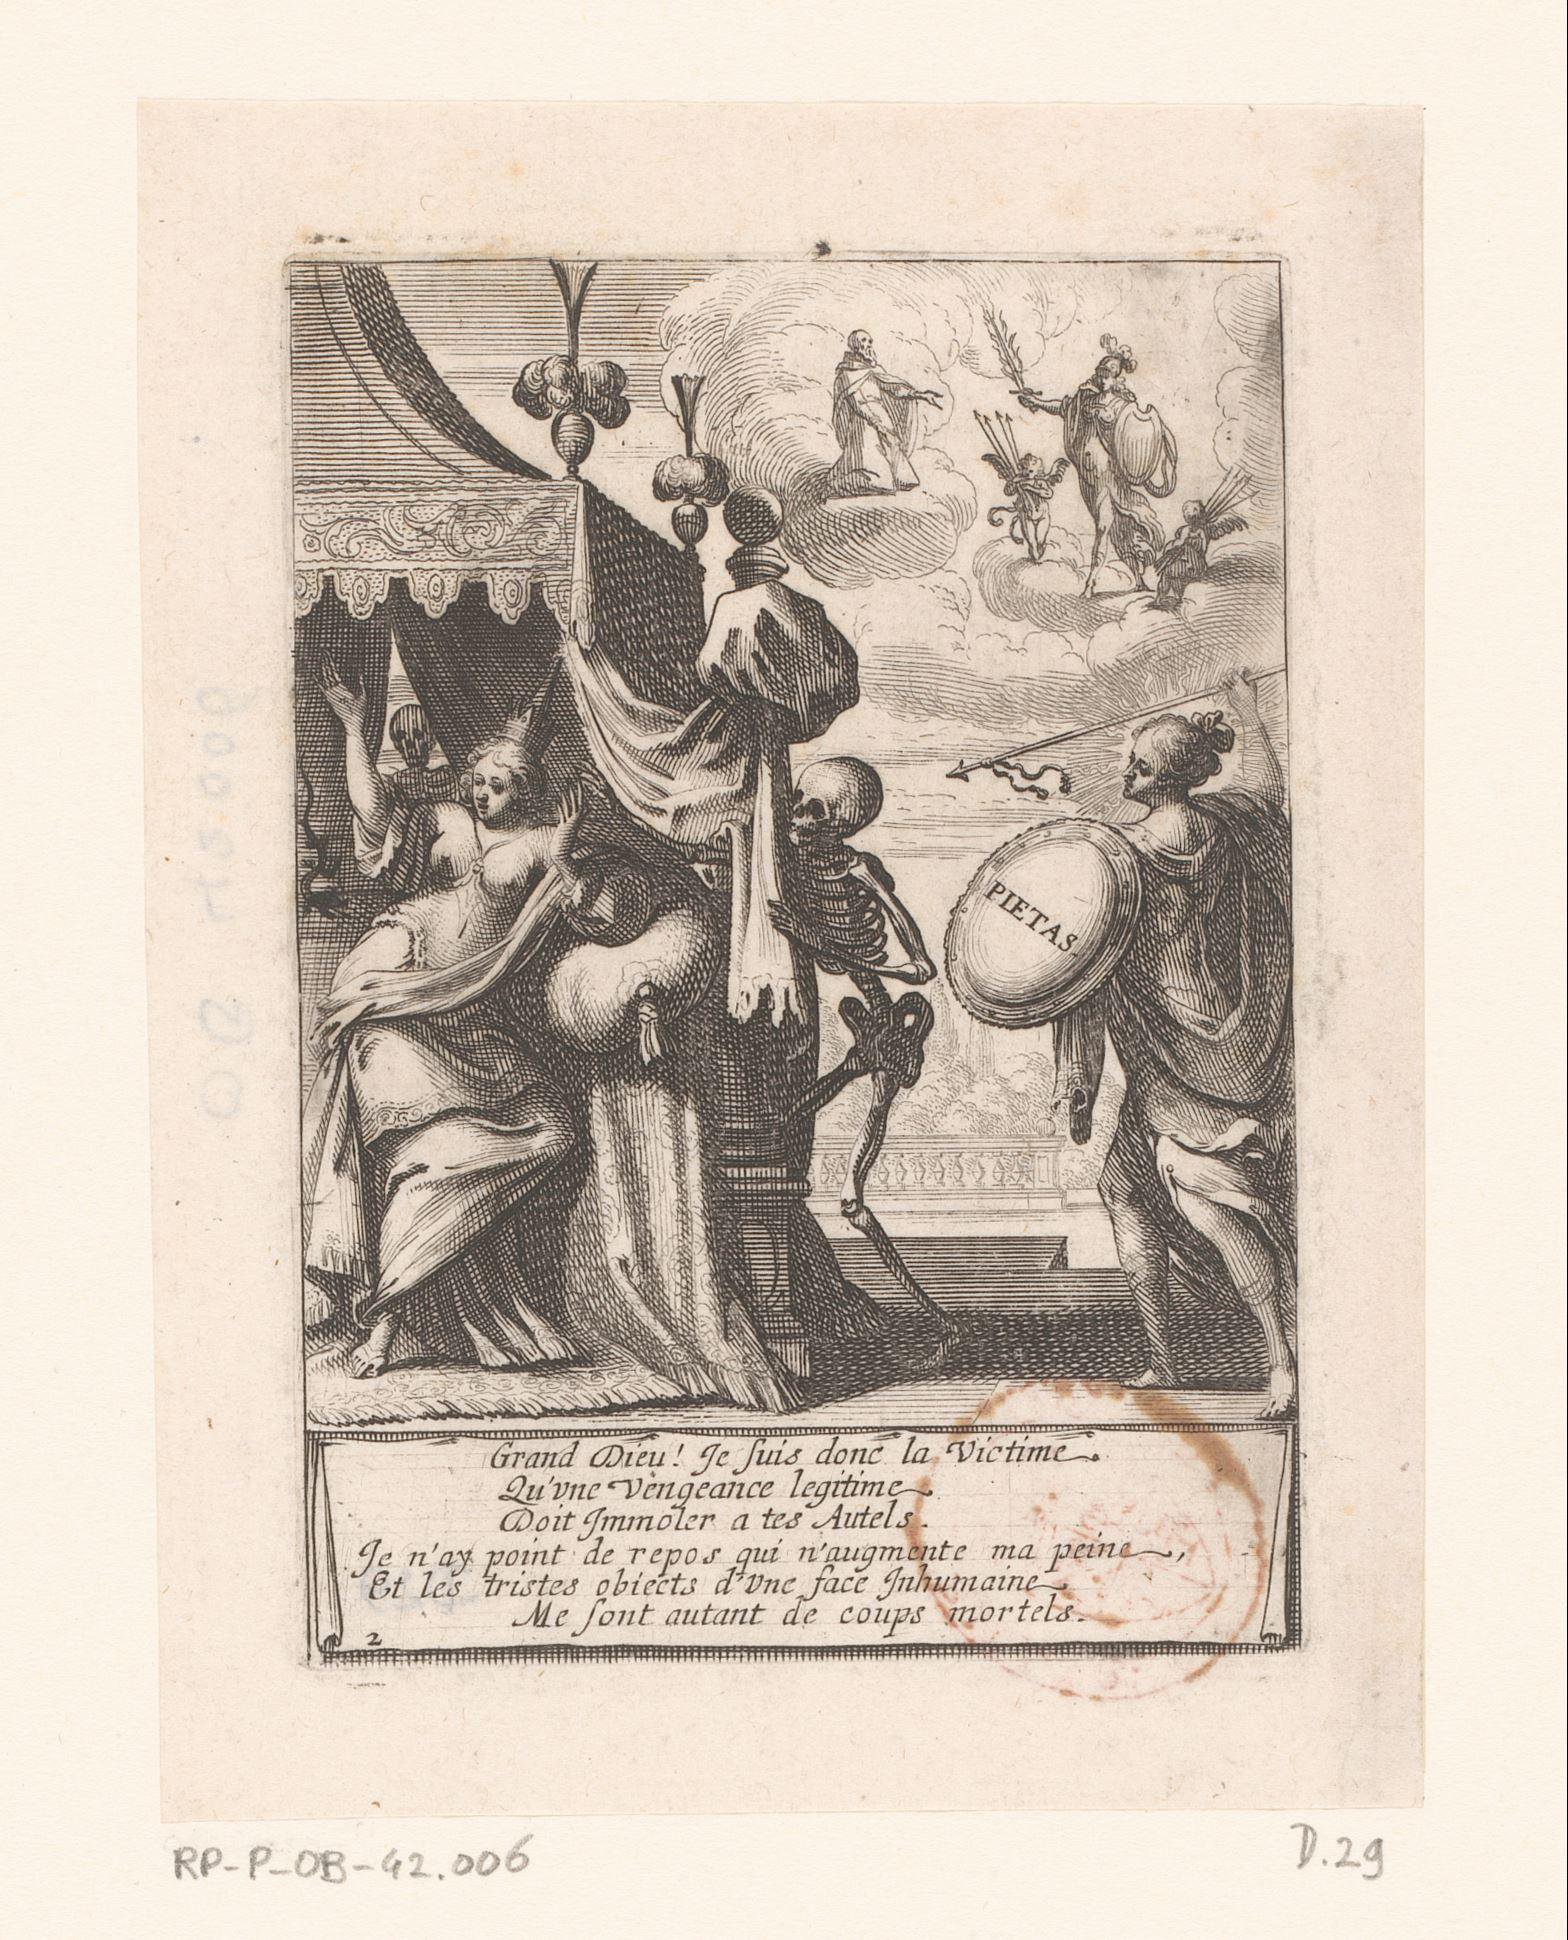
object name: print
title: Izebel door een personificatie van de Vroomheid (Piétas) aangevallen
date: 1635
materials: paper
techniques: engraving, etching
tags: jezebel (not in biblical context), 'pietas'; 'pietà' (ripa)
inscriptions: collector's mark: Lugt 240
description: Prent uit: Bosse, Abraham. Jezabel ou l'Impieté punie. Rouen: College royal et archiepiscopal de Bourbon de la Compagnie de Jesus, 1635.